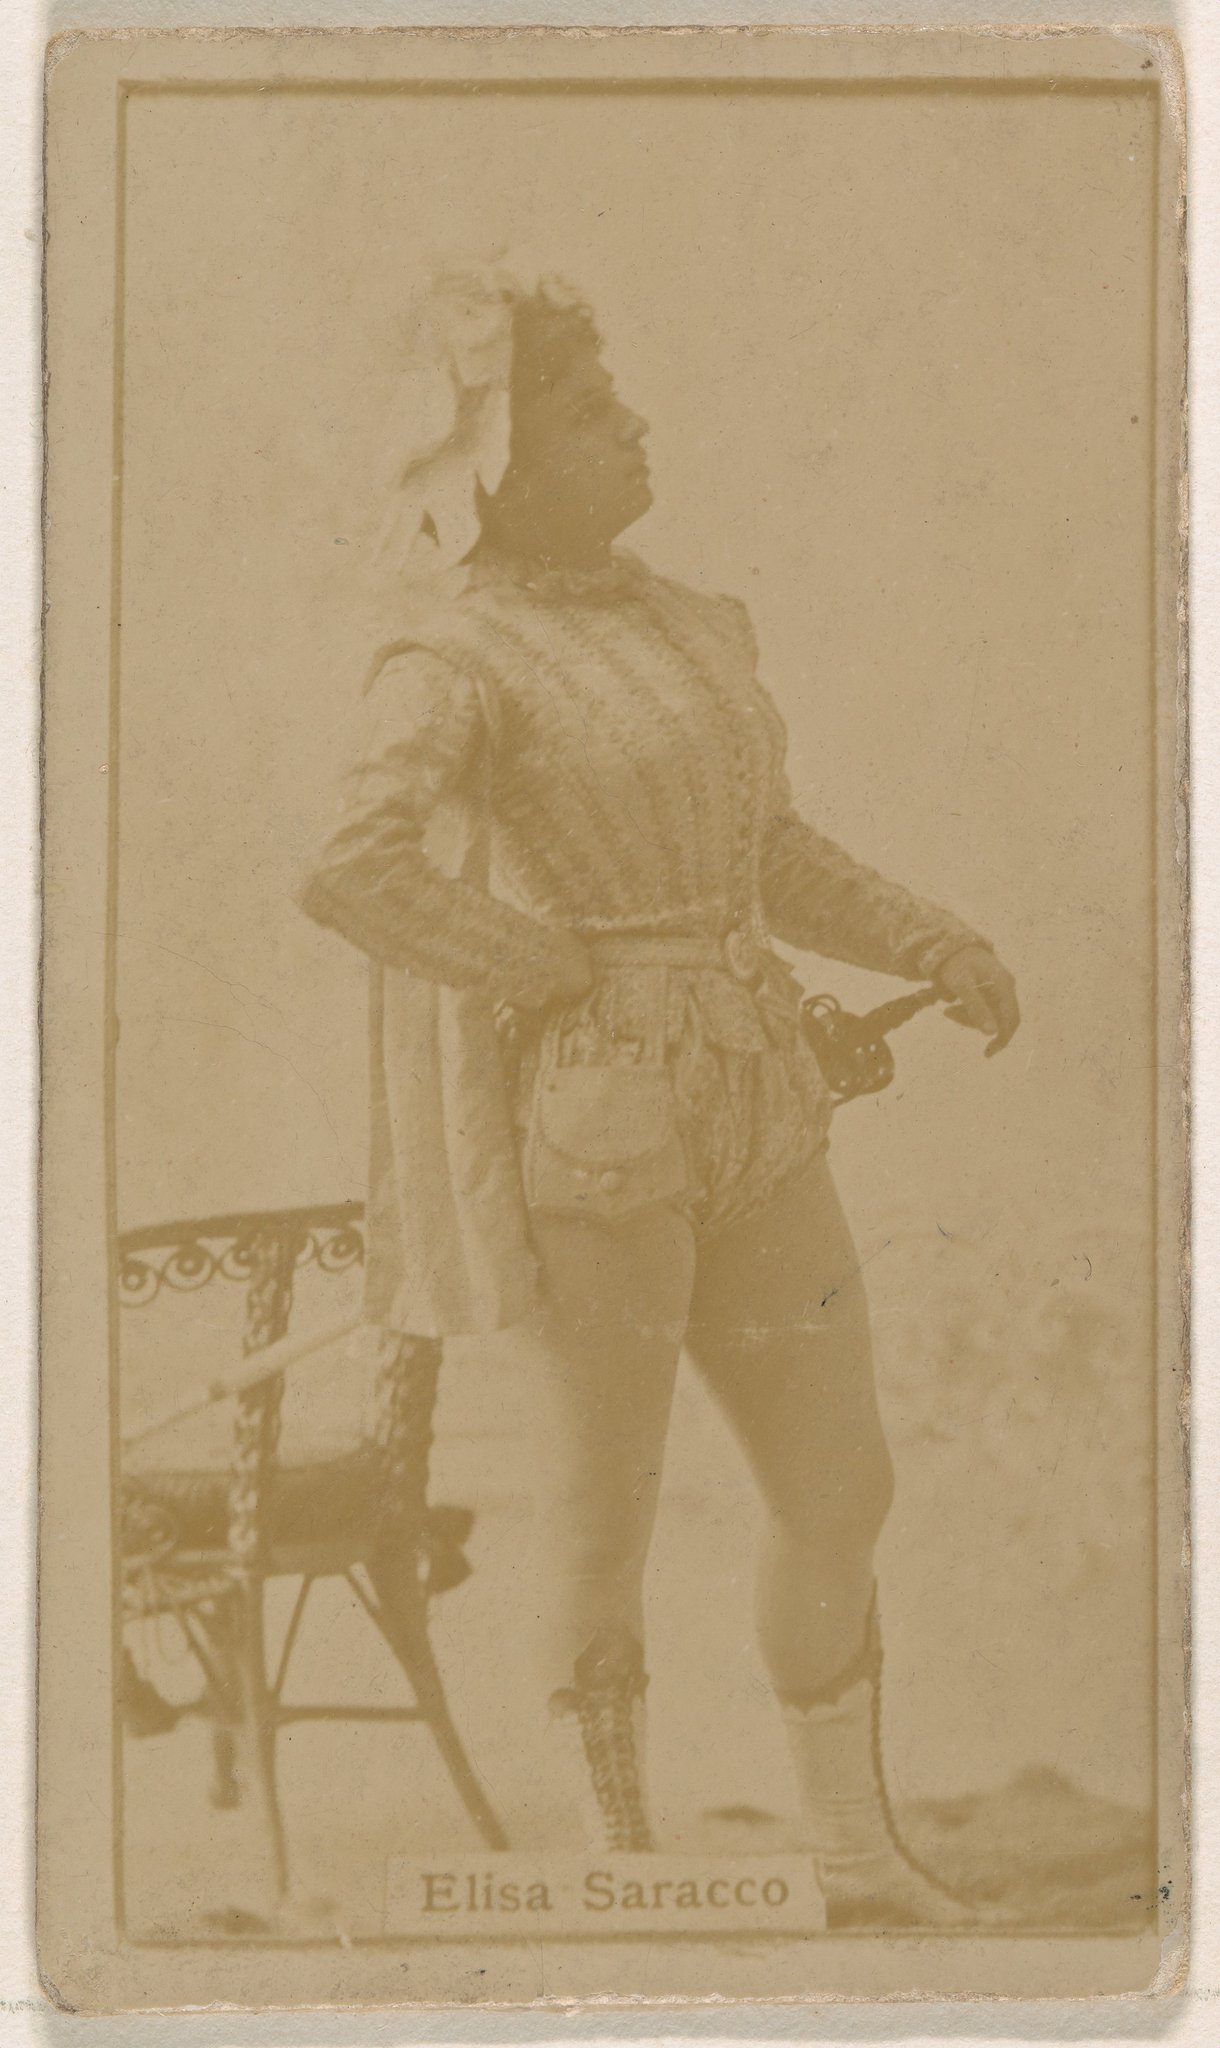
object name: photograph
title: Mlle. Elisa Saracco, from the Actresses series (N245) issued by Kinney Brothers to promote Sweet Caporal Cigarettes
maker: kinney brothers tobacco company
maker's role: publisher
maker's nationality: american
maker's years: 1869-2011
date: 1890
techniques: albumen silver print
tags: women,actresses